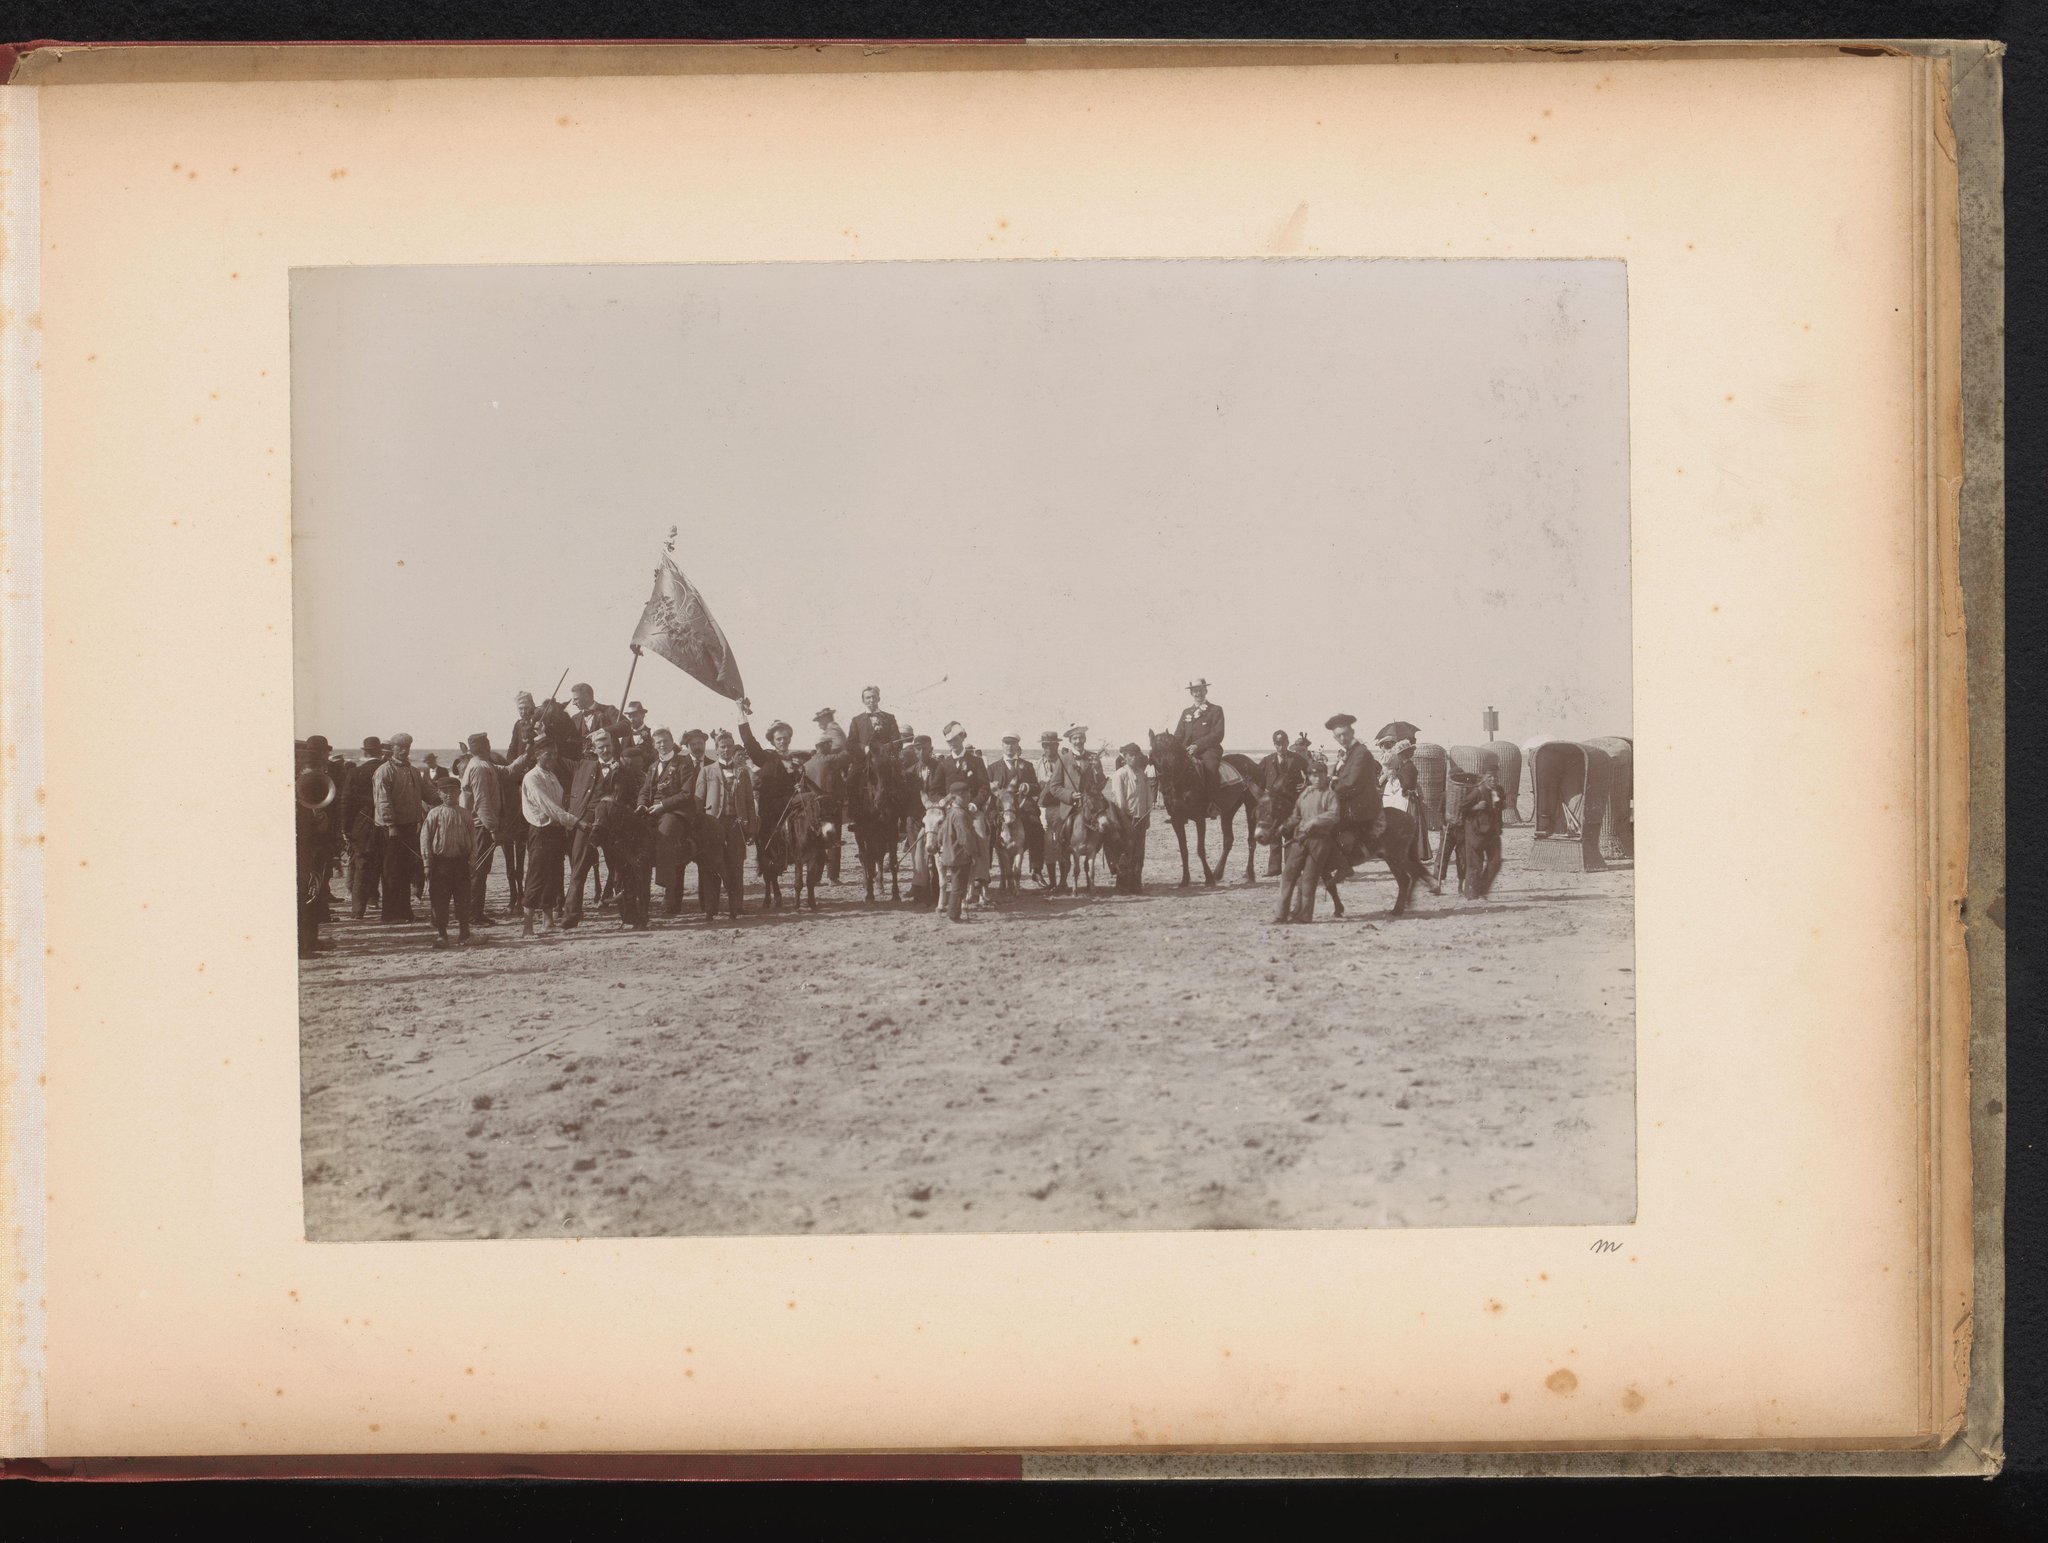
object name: photograph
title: Groepsportret van leden van het Amsterdamsch Studenten Corps op pony's op het strand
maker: nicolaas schuitvlot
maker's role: fotograaf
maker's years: 1859-1947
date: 1806-1897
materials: cardboard, photographic support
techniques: collodion silver print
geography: netherlands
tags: students' organization, horse, beach, anonymous historical persons portrayed in a group, in a group-portrait, netherlands